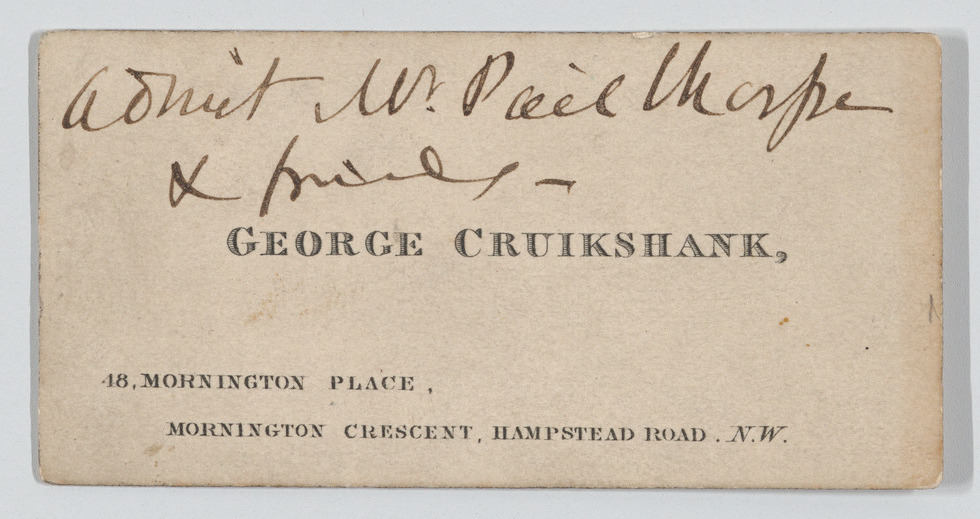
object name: print, calling card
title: George Cruikshank, calling card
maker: Anonymous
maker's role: artist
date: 1830-1878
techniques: engraving